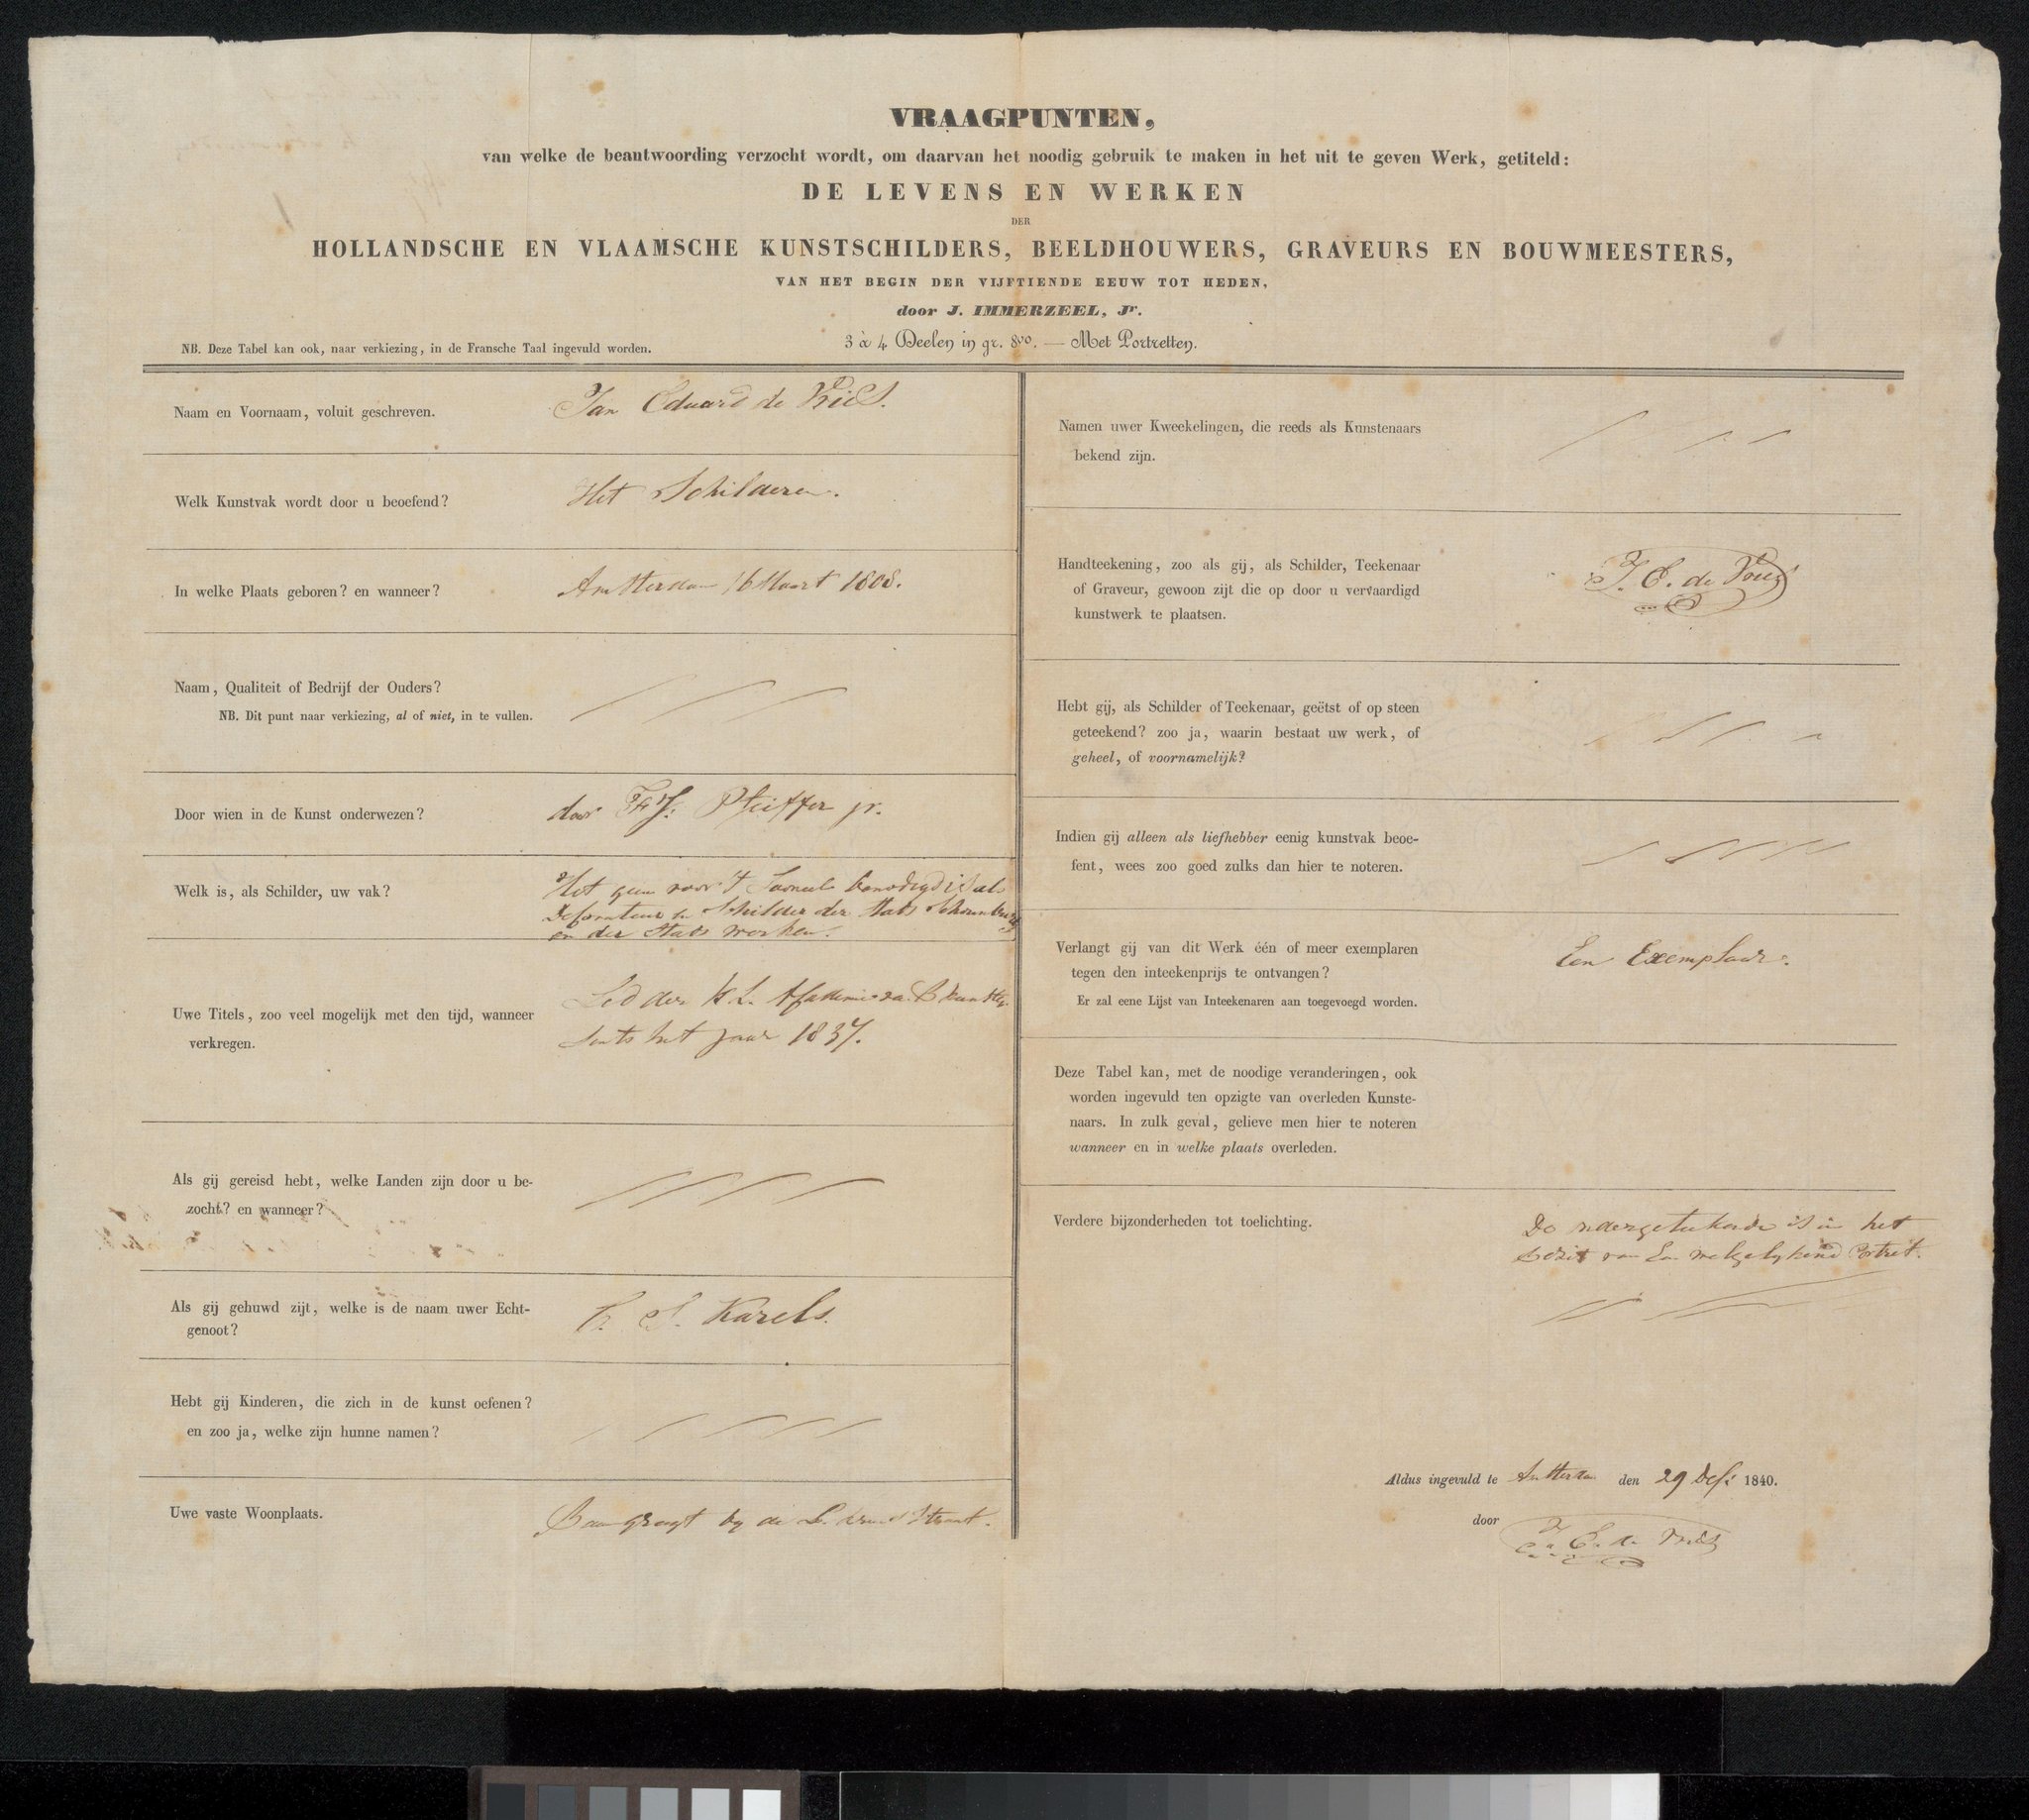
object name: manuscript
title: Enquêteformulier ingevuld door Jan Eduard de Vries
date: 1840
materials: ink, paper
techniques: pen, printing, writing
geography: amsterdam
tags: amsterdam, painter, jan eduard de vries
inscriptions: watermark, inscription: ‘Vraagpunten,/ van welke de beantwoording verzocht wordt, om daarvan het noodig gebruik te maken in het uit te geven Werk, getiteld: De levens en werken/ der Hollandsche en Vlaamsche kunstschilders, beeldhouwers,/ graveurs en bouwmeesters, van het begin der vijftiende eeuw tot heden/ door J. Immerzeel, Jr.’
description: Opgenomen in: Immerzeel, J. Jr., De levens en werken der Hollandsche en Vlaamsche kunstschilders, beeldhouwers, graveurs en bouwmeesters, van het begin der vijftiende eeuw tot heden, Amsterdam: J.C. van Kesteren, 1842-1843.